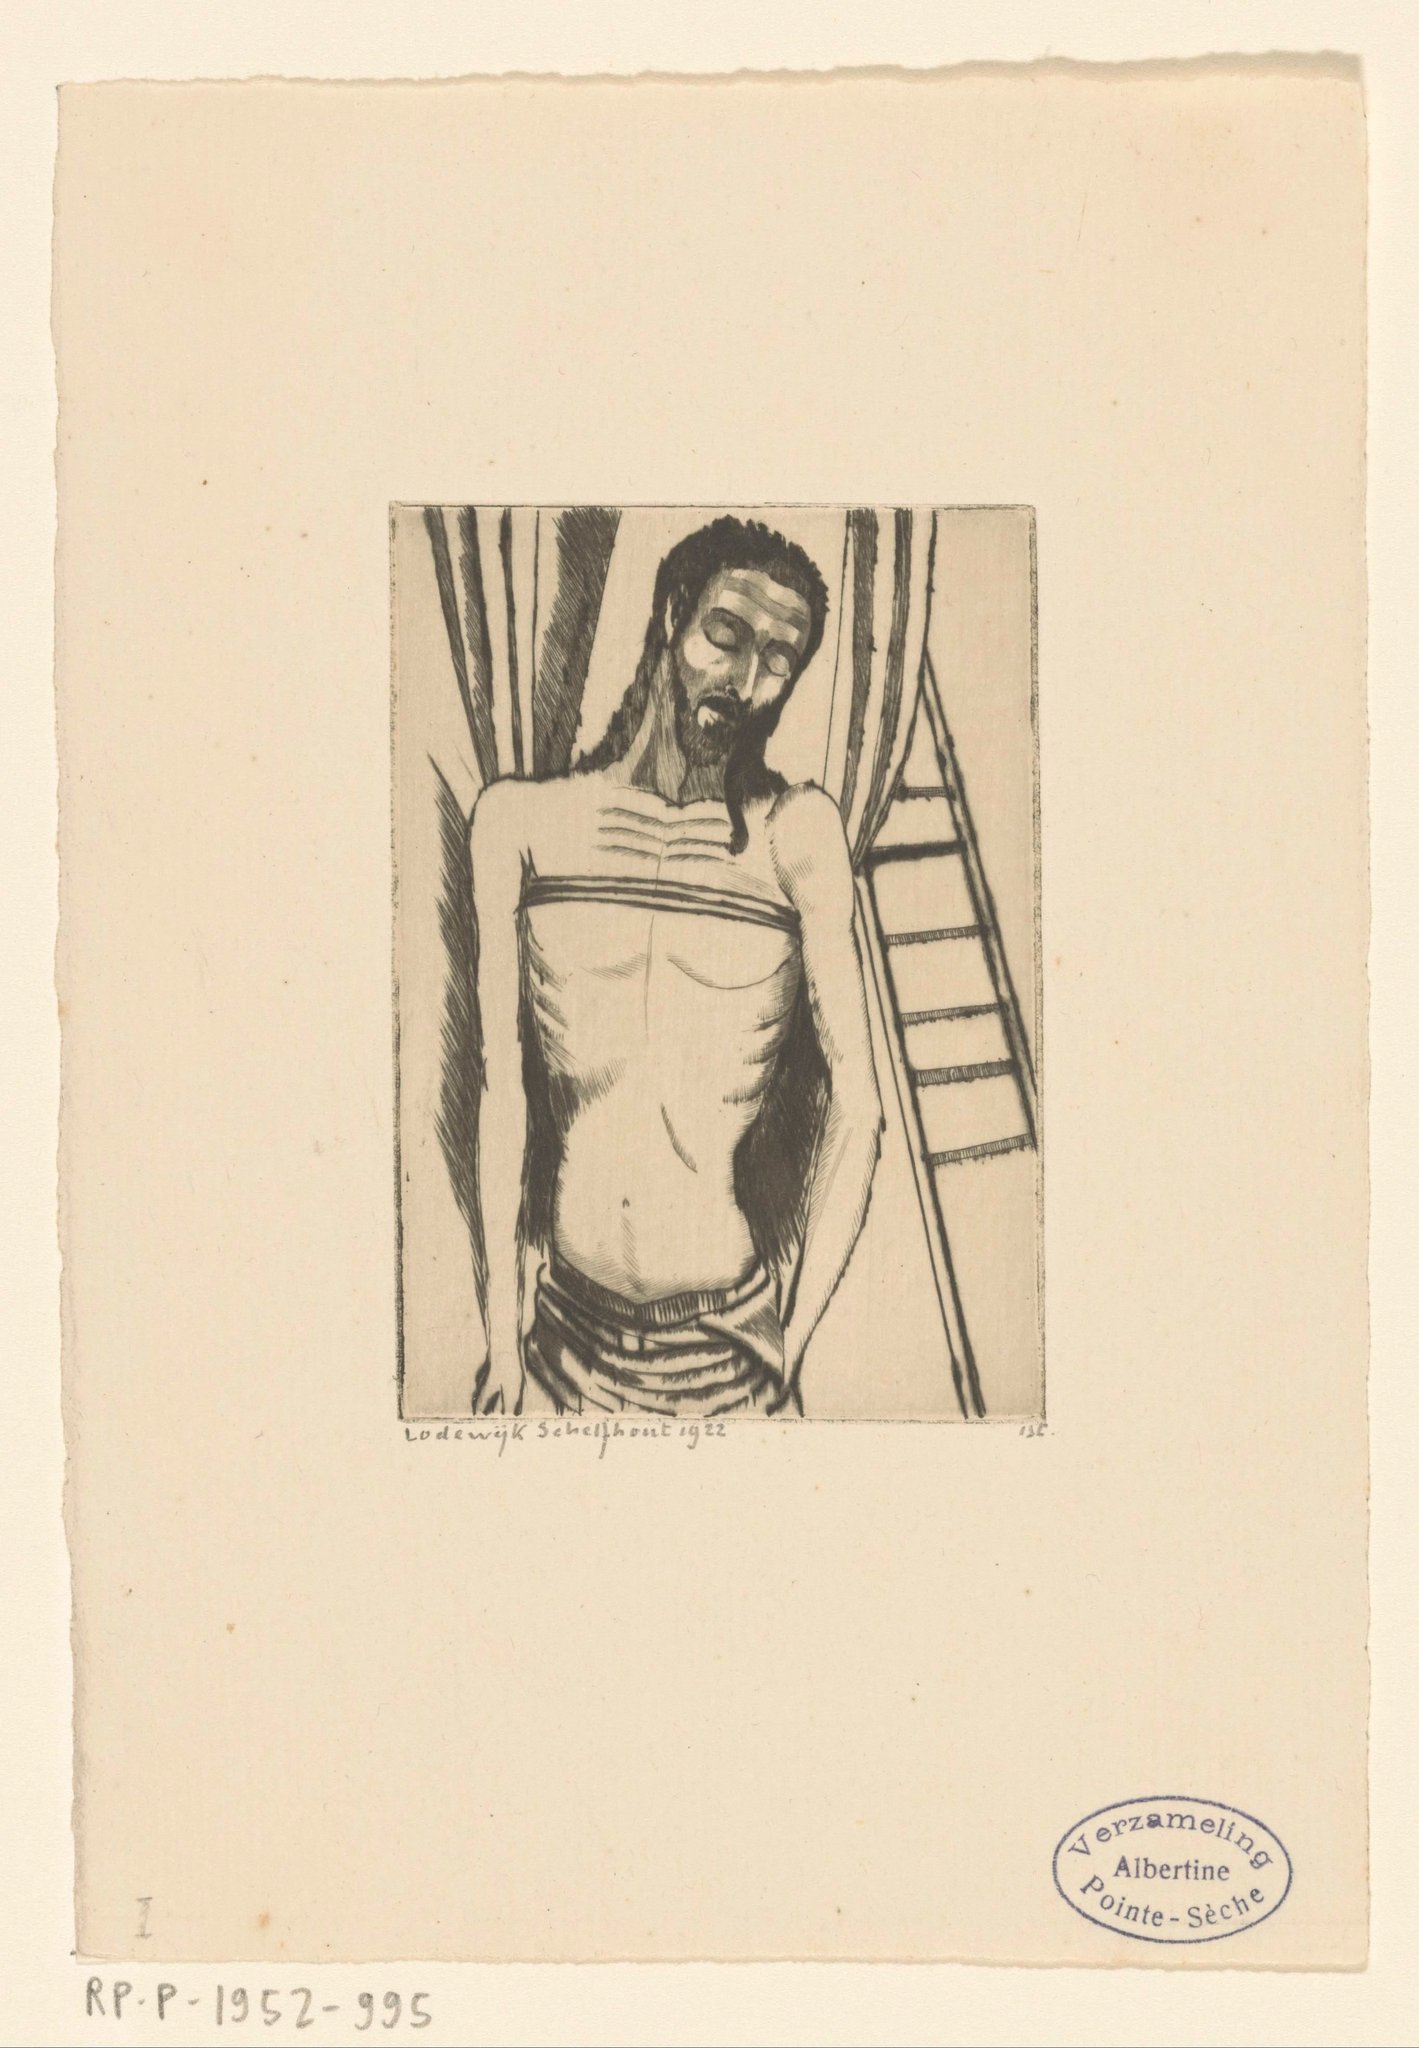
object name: print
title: Christus, hangend aan een doek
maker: lodewijk schelfhout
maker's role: draughtsman, print maker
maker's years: 1881-1943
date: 1922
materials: paper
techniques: drypoint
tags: from christ's deposition to his entombment (matthew 27:58-66; mark 15:46-47; luke 23:53-56; john 19:39-42)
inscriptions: collector's mark: Lugt 5i, collector's mark: Lugt 2228, collector's mark: Lugt 2760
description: Naast Christus de ladder die tijdens de kruisafneming is gebruikt.